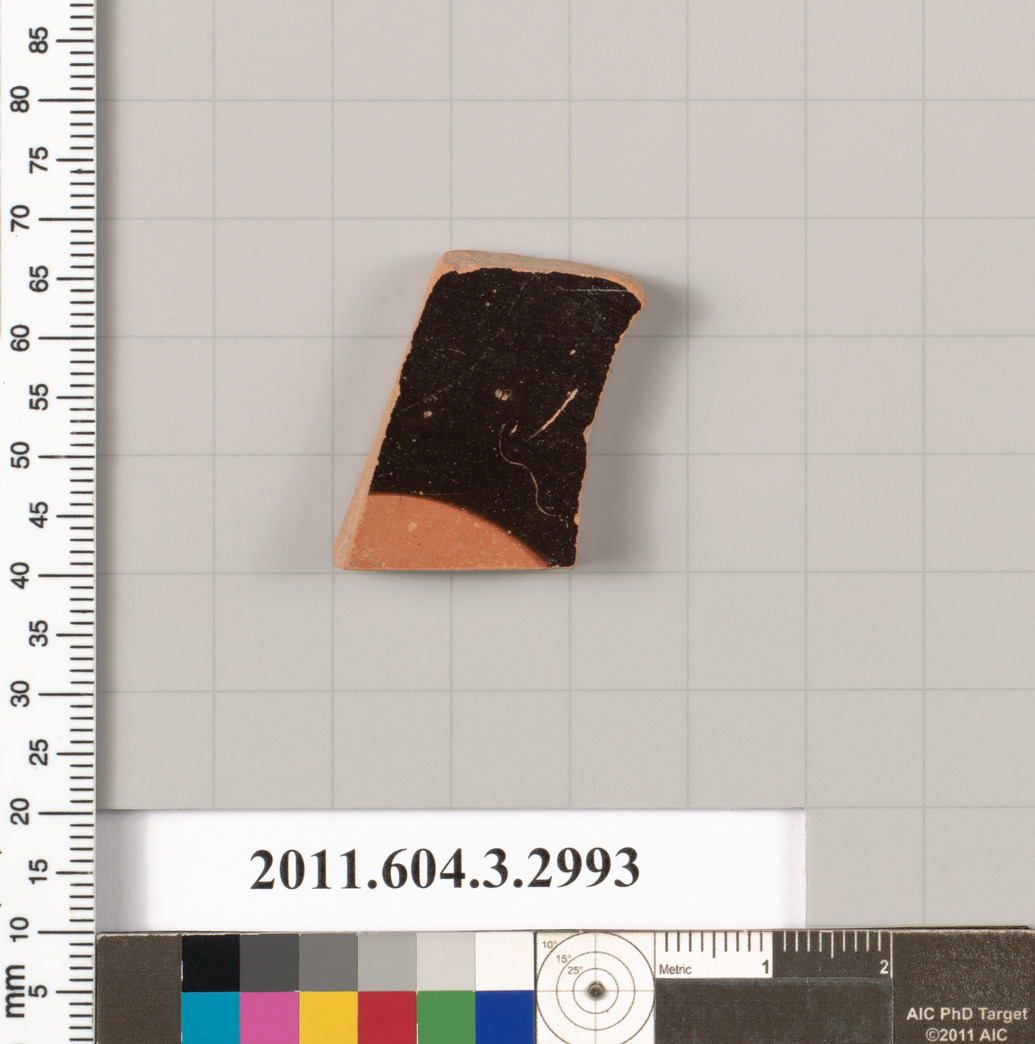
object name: kylix fragment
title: Terracotta fragment of a kylix (drinking cup)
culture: greek, attic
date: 534-468 BCE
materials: terracotta